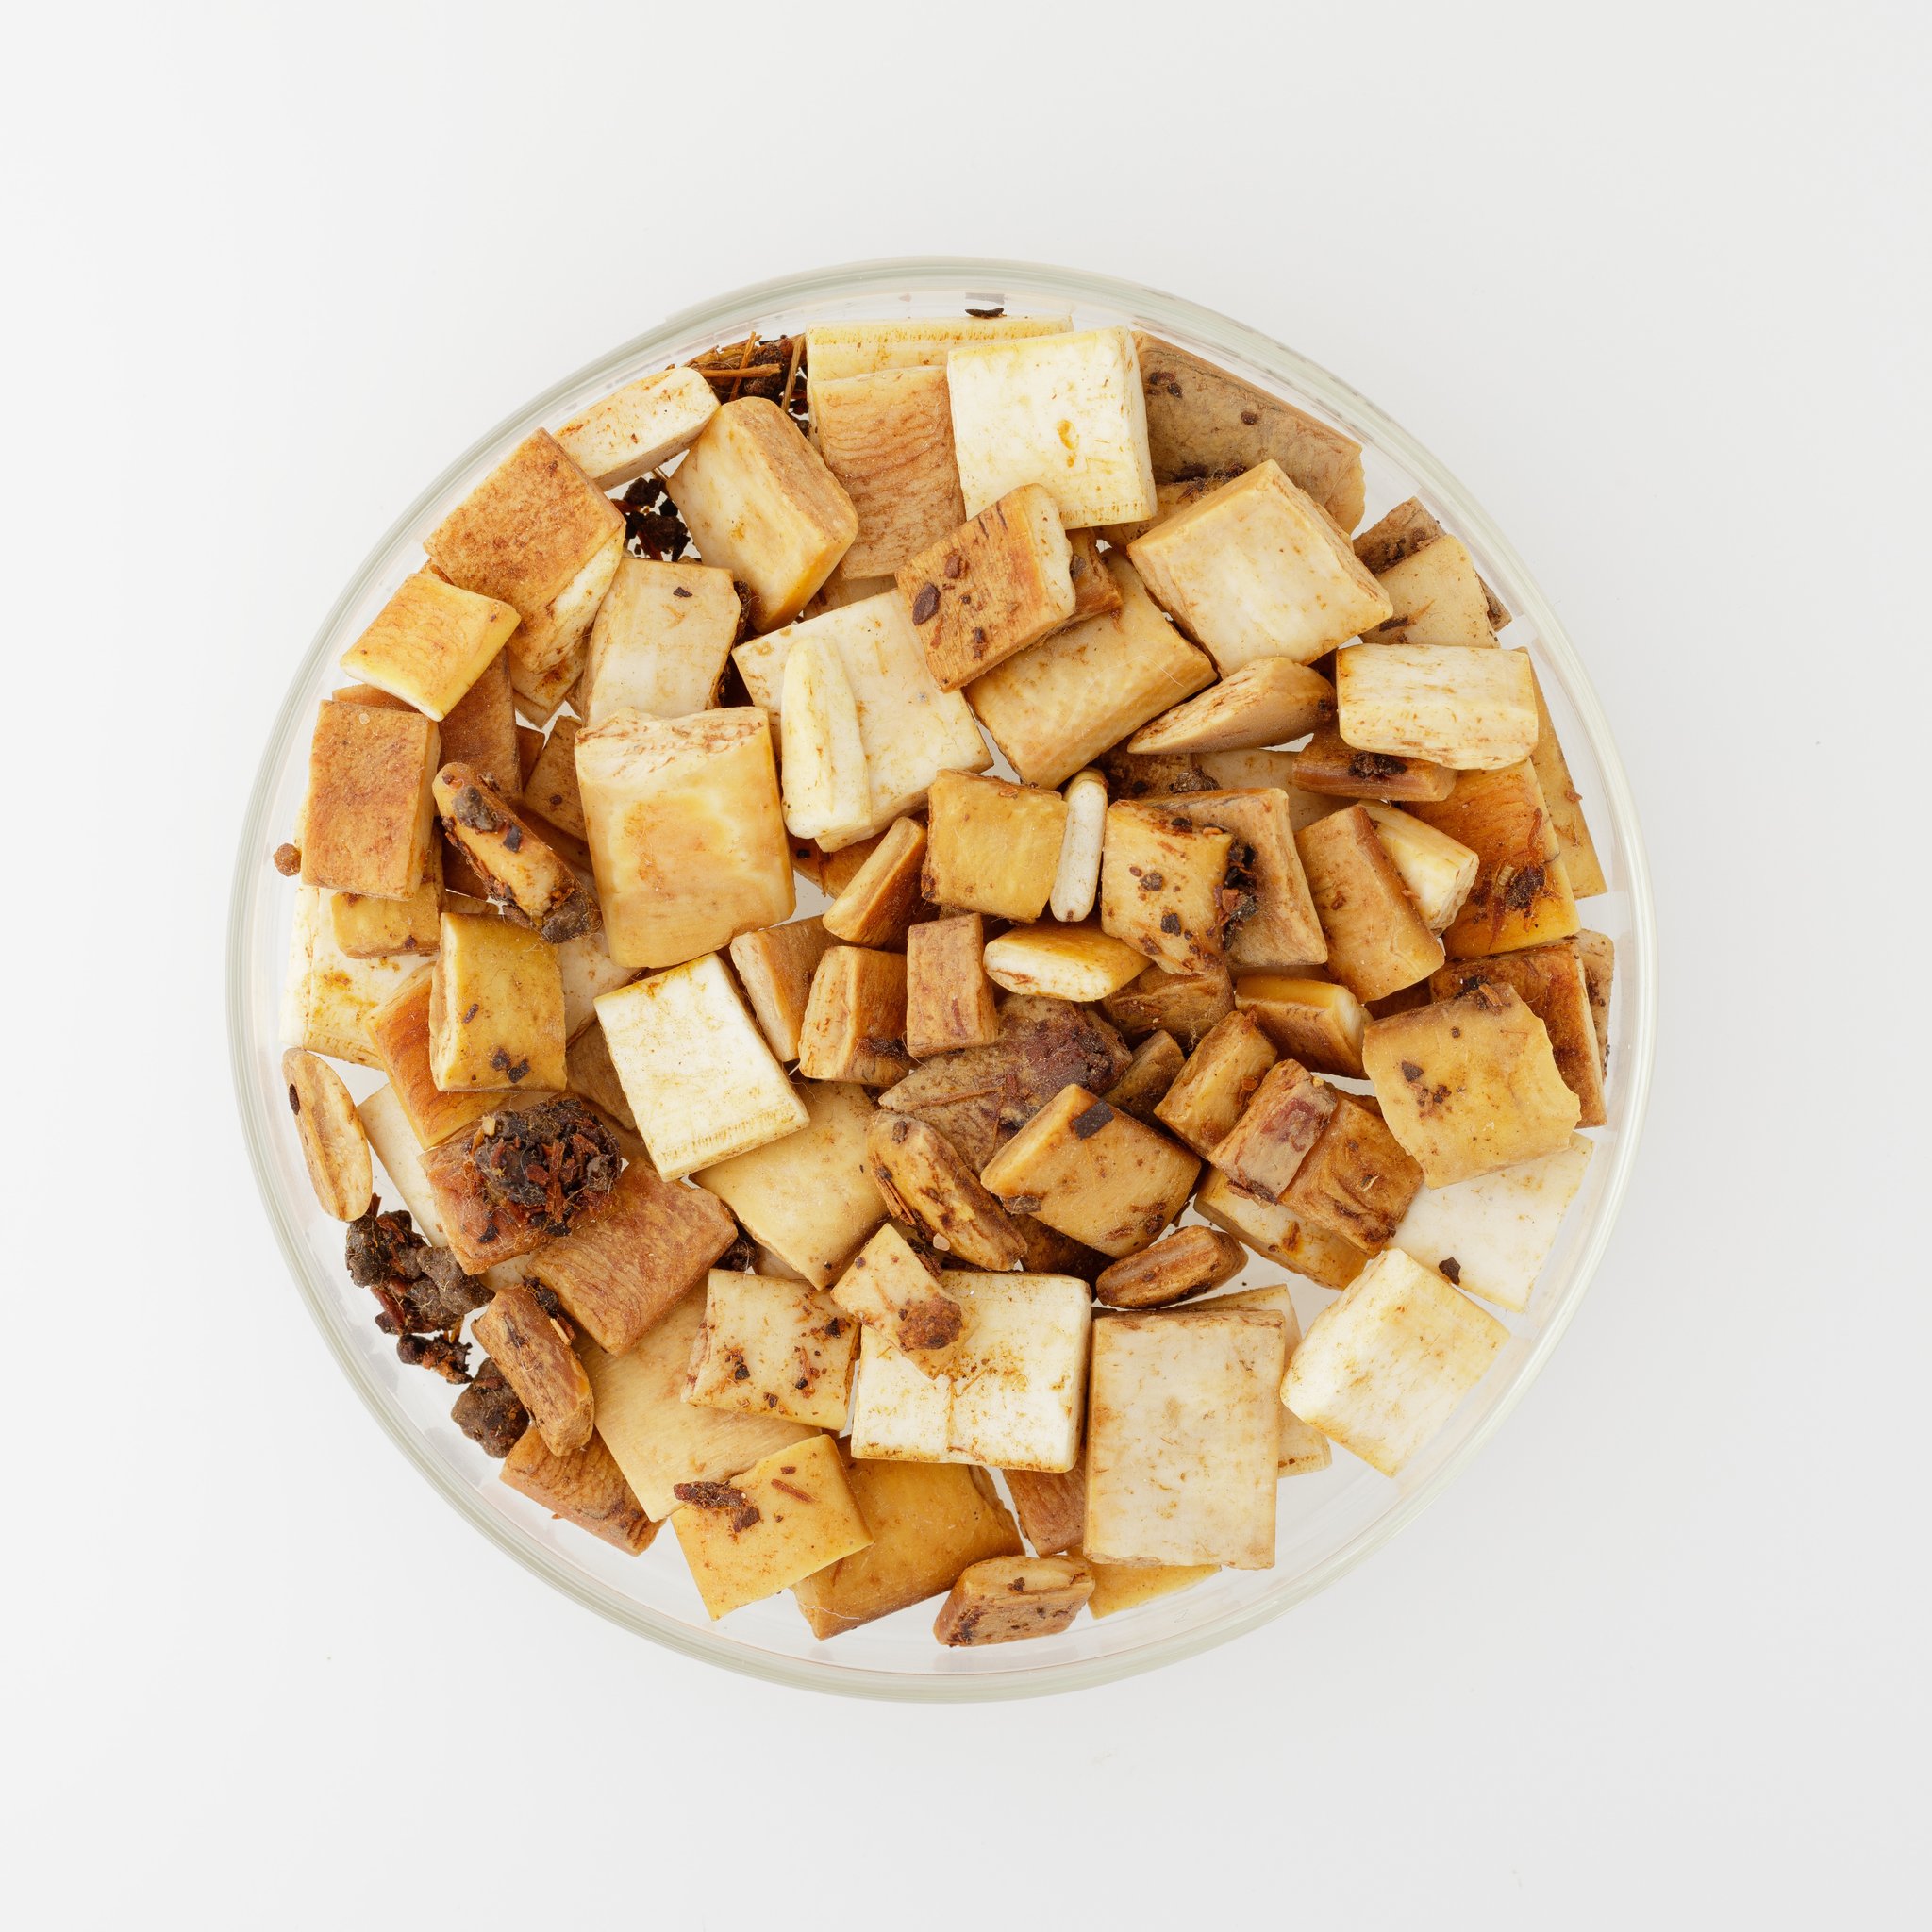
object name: bracelet fragment dish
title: Bracelet fragments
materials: ivory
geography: egypt